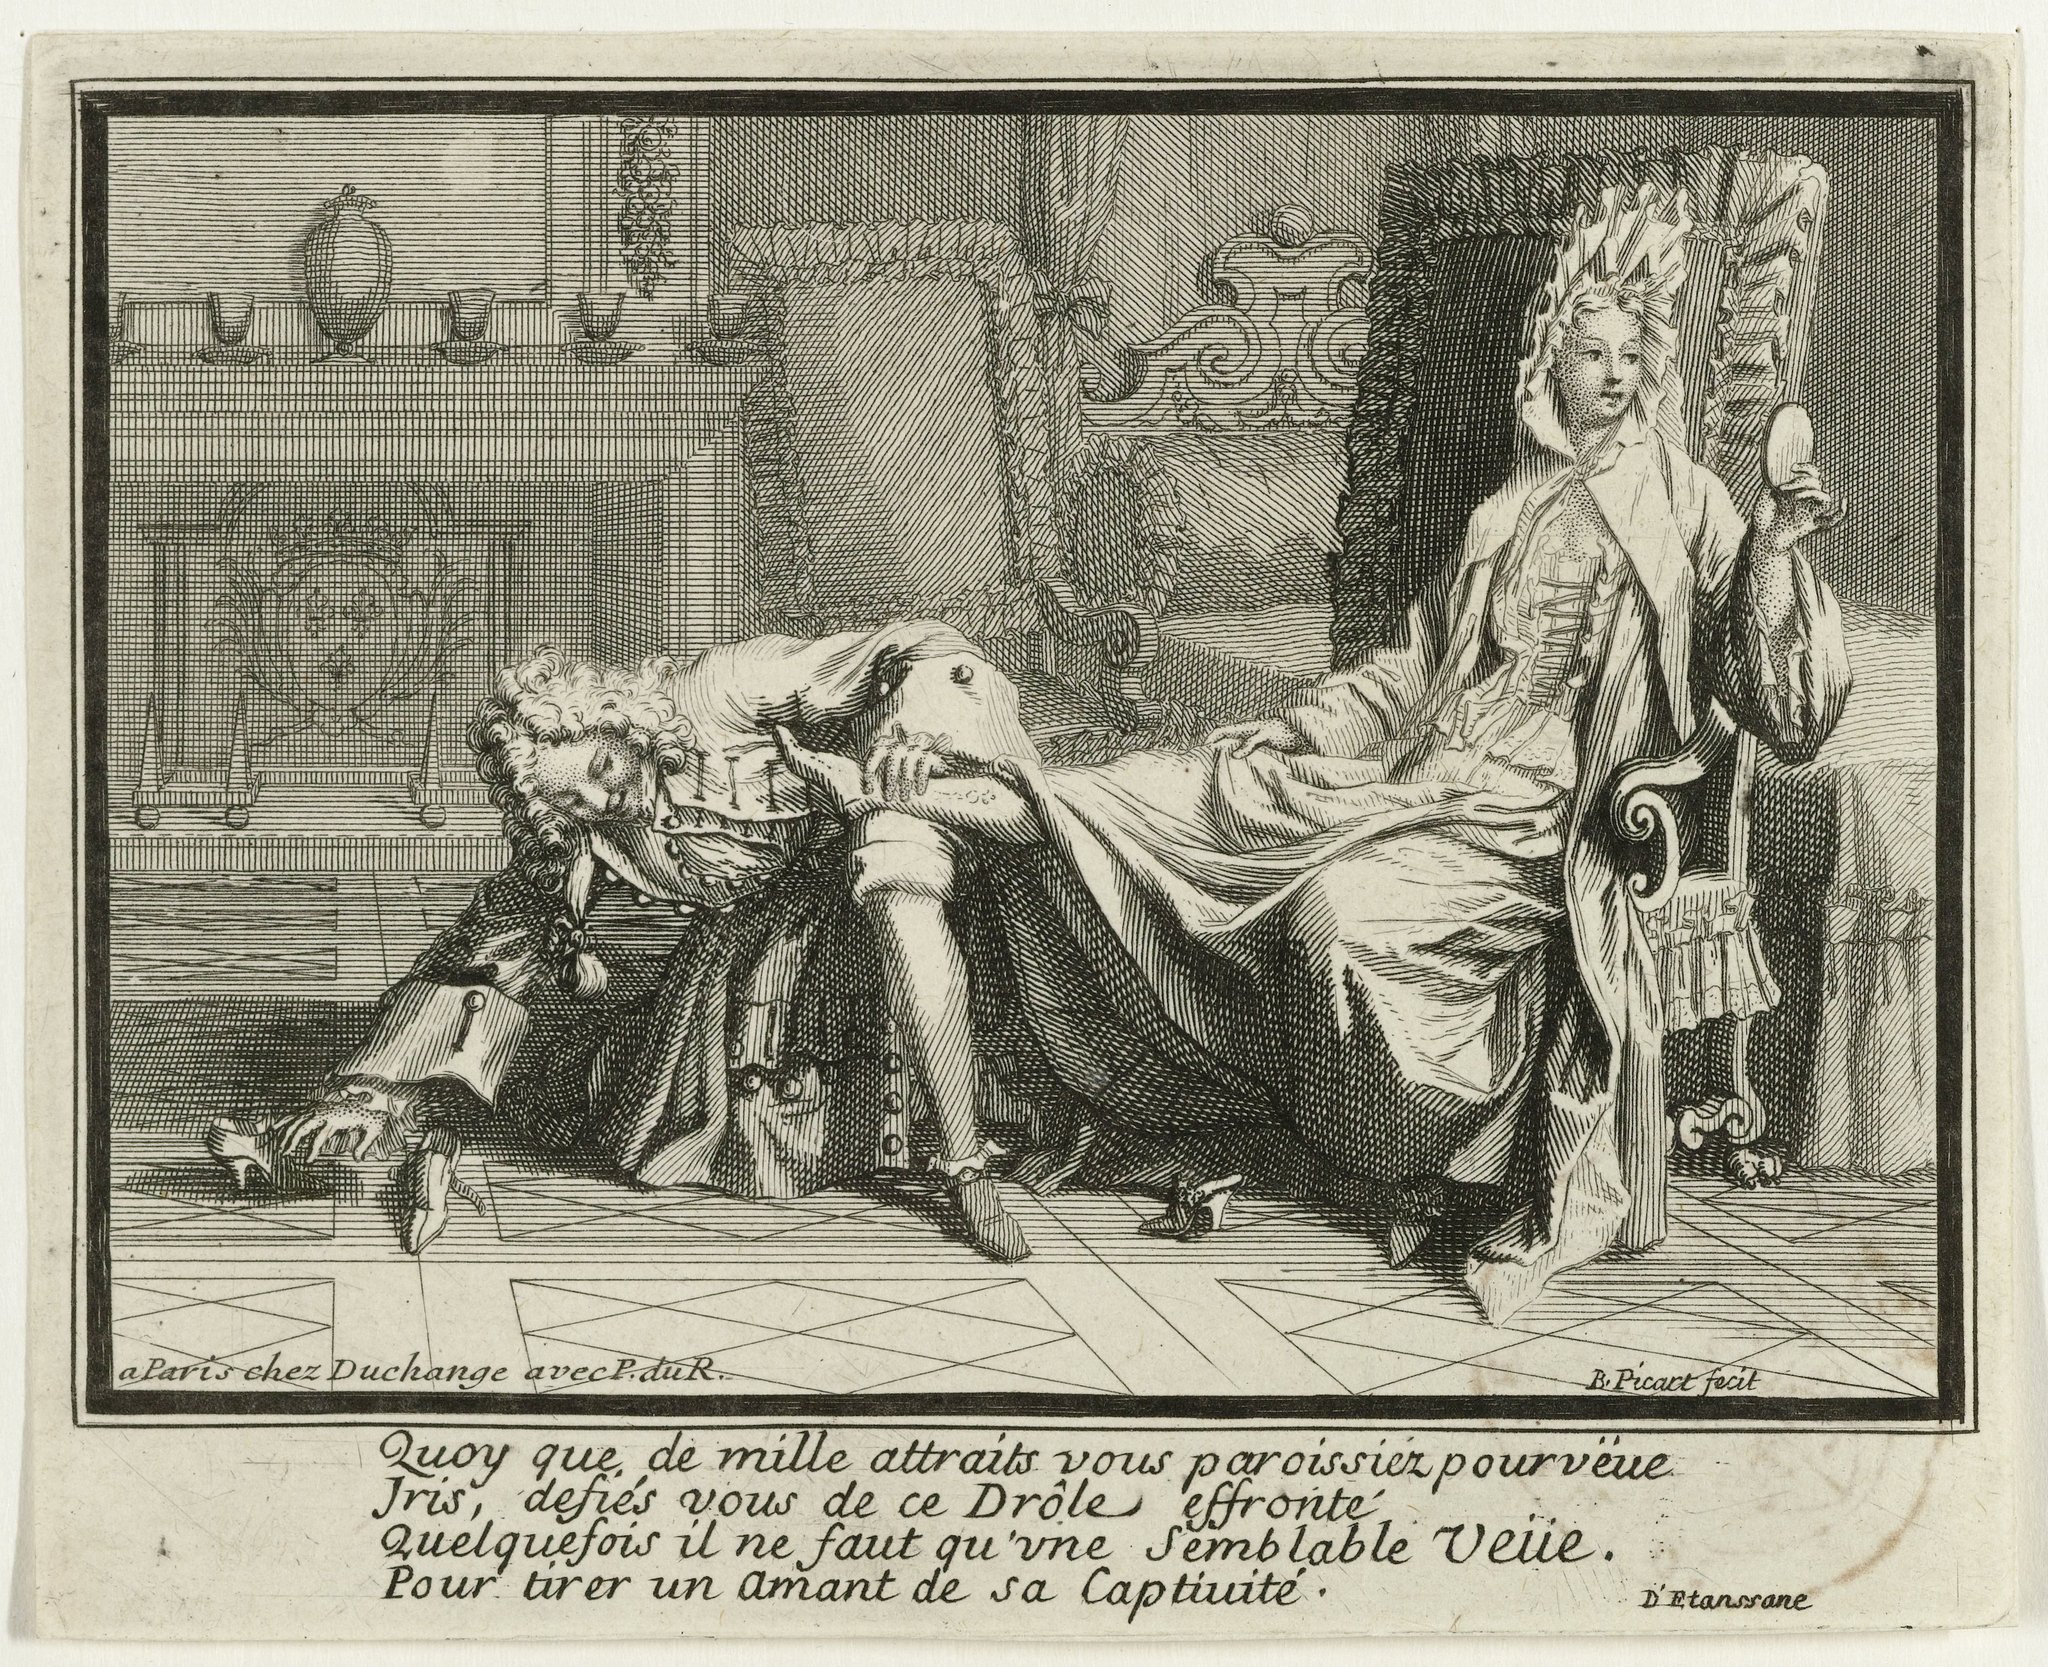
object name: print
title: De vijf zintuigen voorgesteld door elegante paren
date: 1683-1710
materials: paper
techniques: engraving, etching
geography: paris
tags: sight, looking (one of the five senses)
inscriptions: collector's mark: Lugt 240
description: Slaapkamer met een elegant gekleed paar. De vrouw kijkt in een spiegel terwijl de man haar schoenen uittrekt. In de marge een vierregelig gedicht in het Frans.